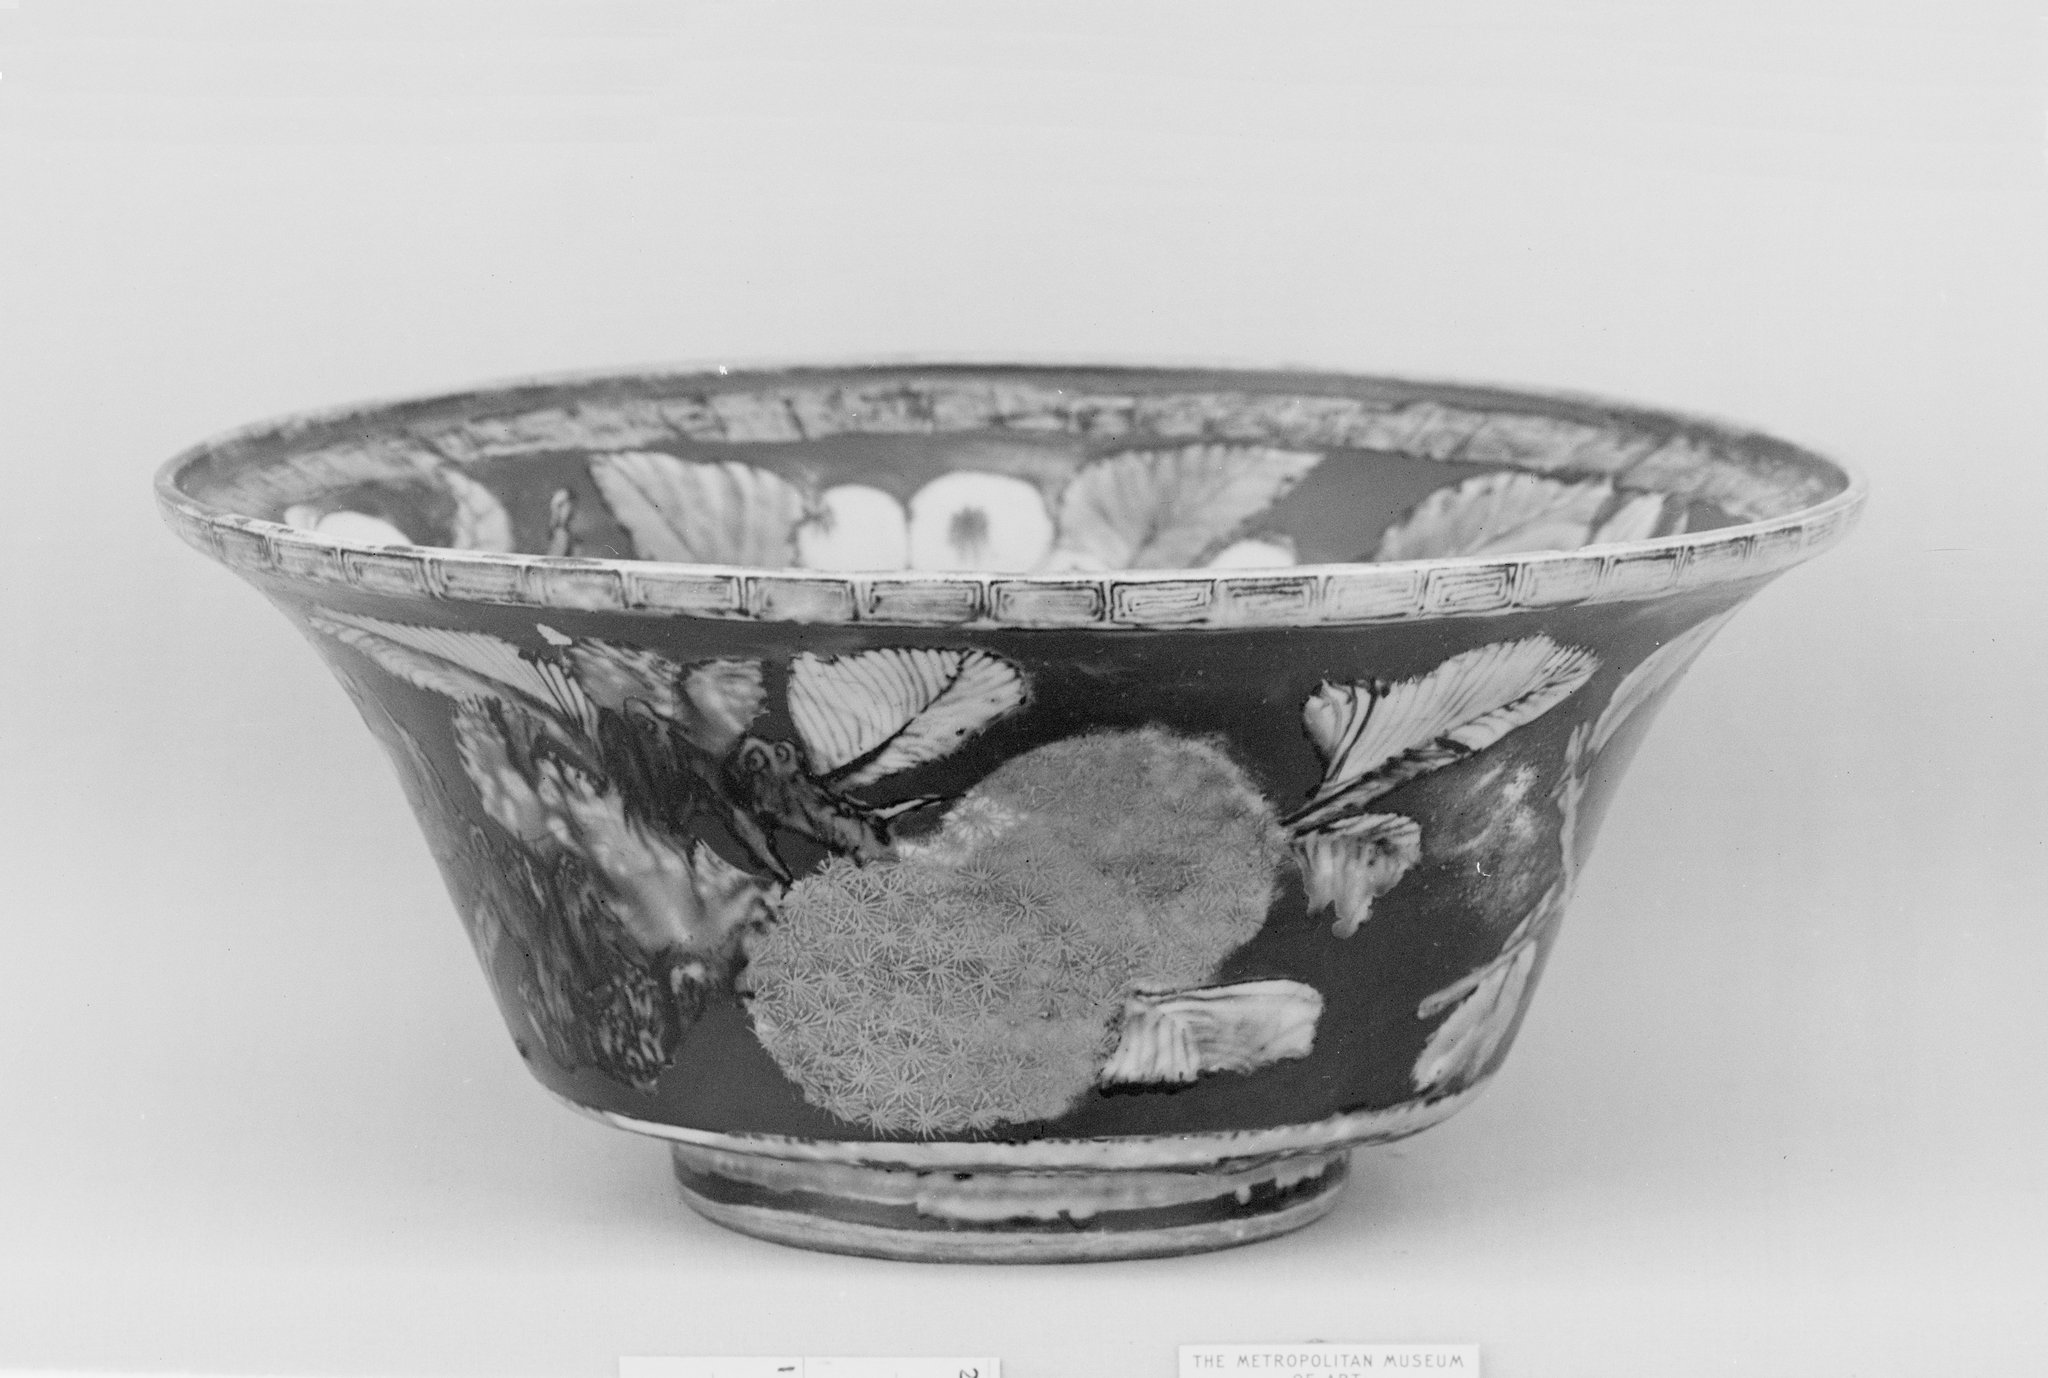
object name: bowl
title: Large Bowl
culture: japanese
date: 1790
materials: pottery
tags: leaves